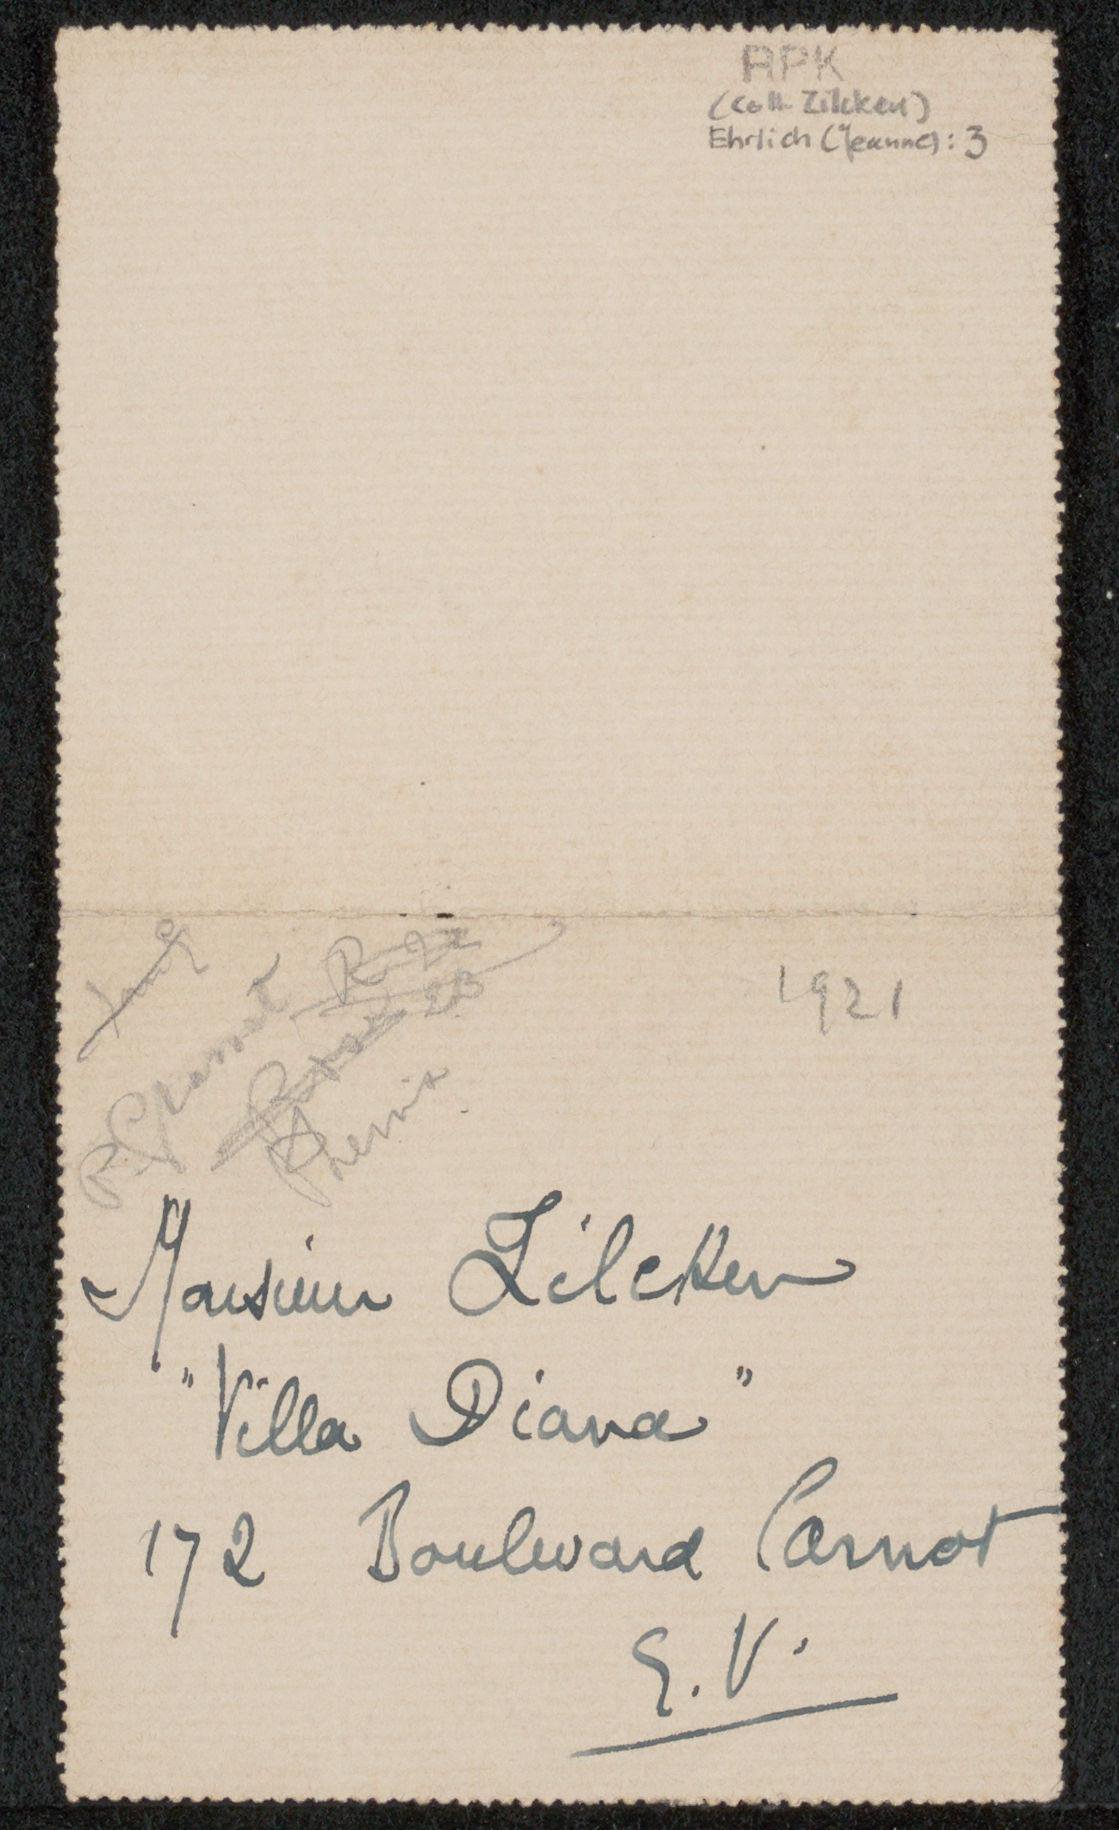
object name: letter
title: Brief aan Philip Zilcken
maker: jeanne erlich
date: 1921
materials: ink, paper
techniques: pen, writing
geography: nice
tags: the hague, painter, philip zilcken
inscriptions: collector's mark: ‘RPK’